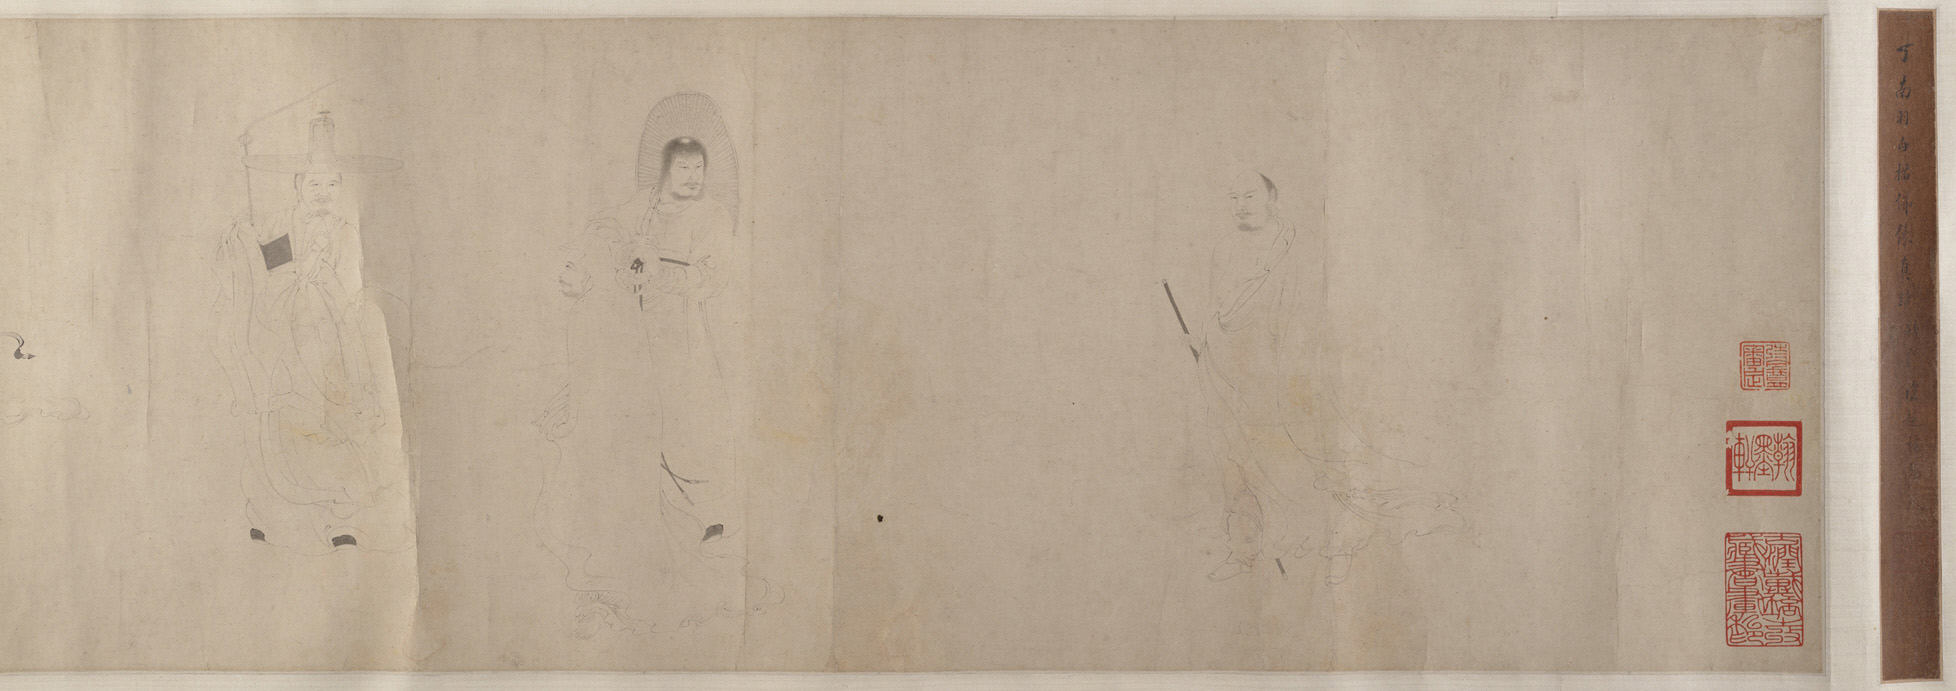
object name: handscroll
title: The Eighteen Luohans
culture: chinese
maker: ding yunpeng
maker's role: artist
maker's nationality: chinese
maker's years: 1547-1621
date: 1801-1900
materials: ink, paper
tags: men